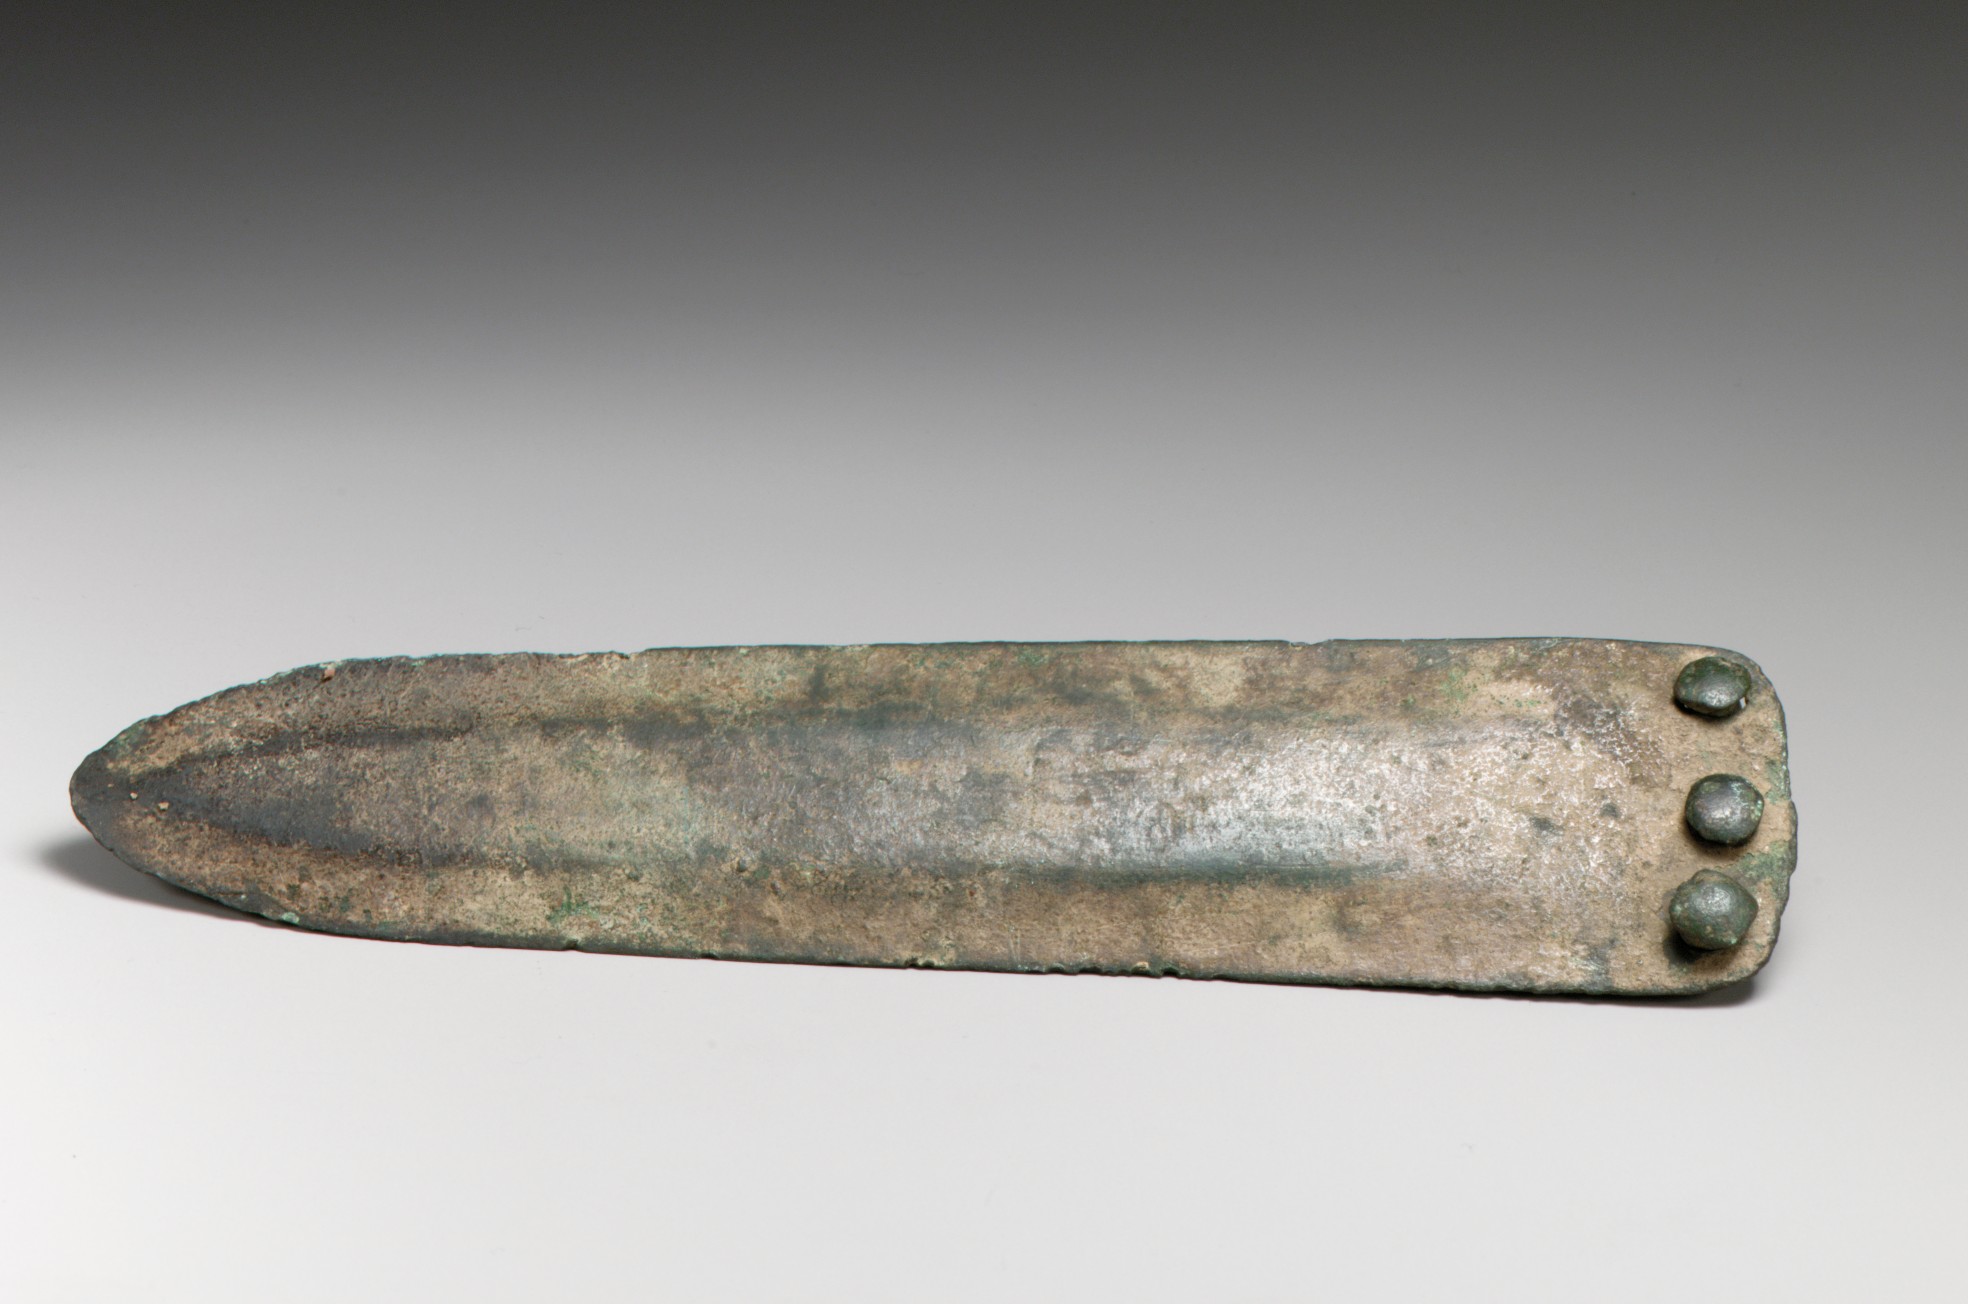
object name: dagger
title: Bronze dagger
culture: minoan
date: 1750-1450 BCE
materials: bronze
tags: daggers